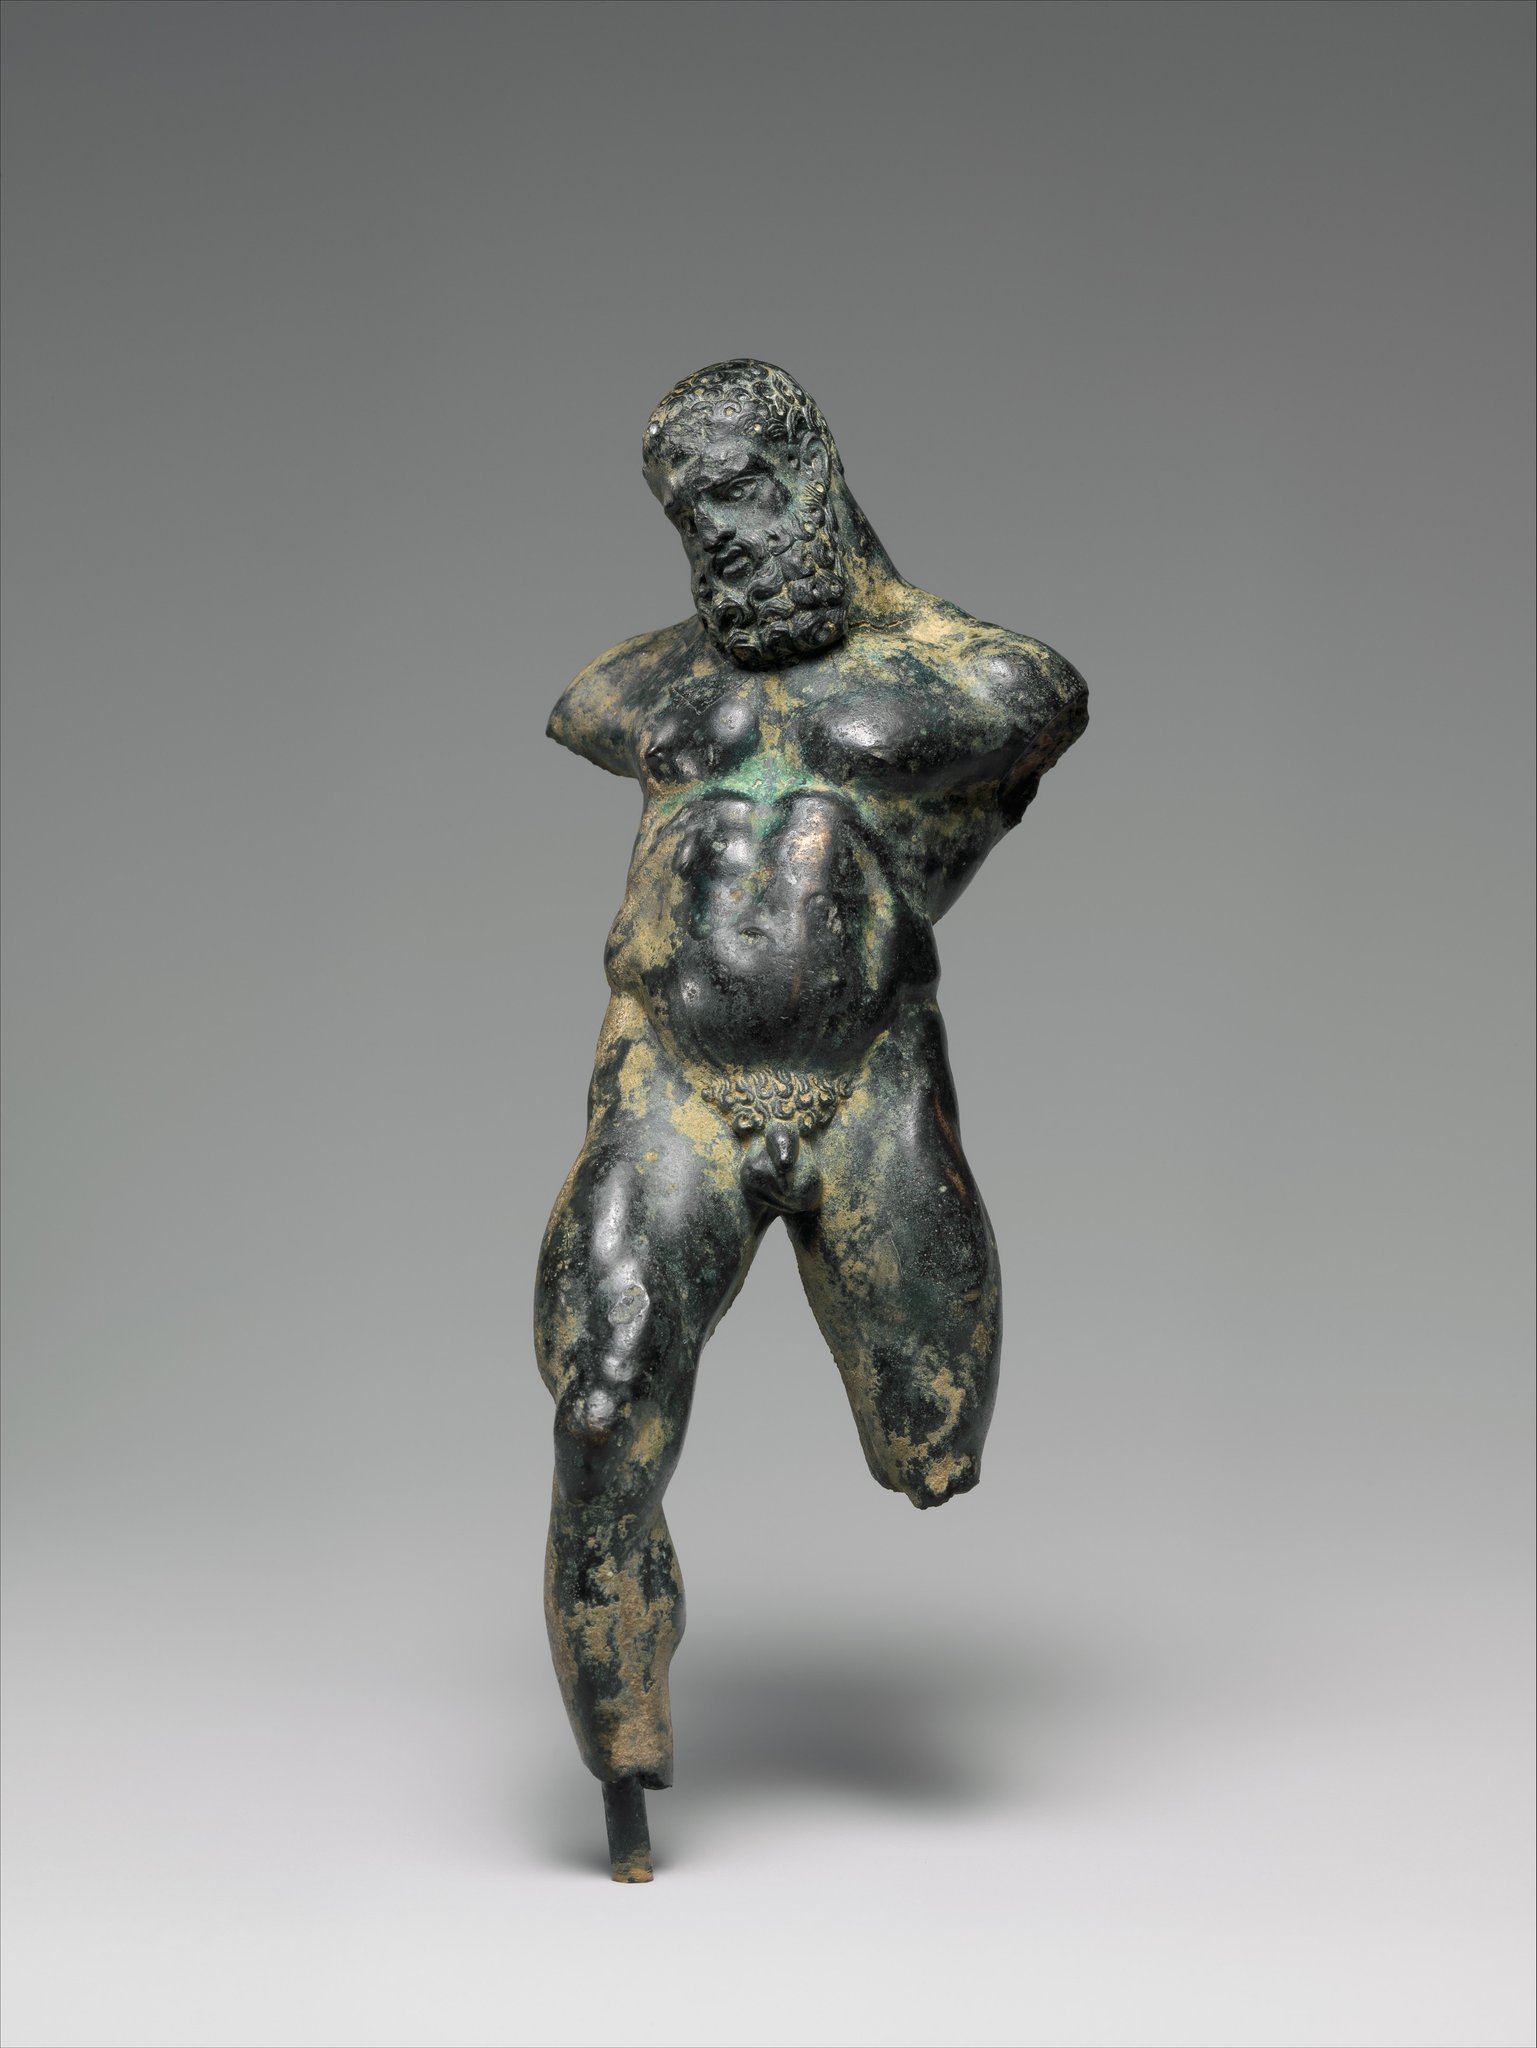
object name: statuette of herakles, drunken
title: Bronze statuette of drunken Herakles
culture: greek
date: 300-101 BCE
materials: bronze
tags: male nudes